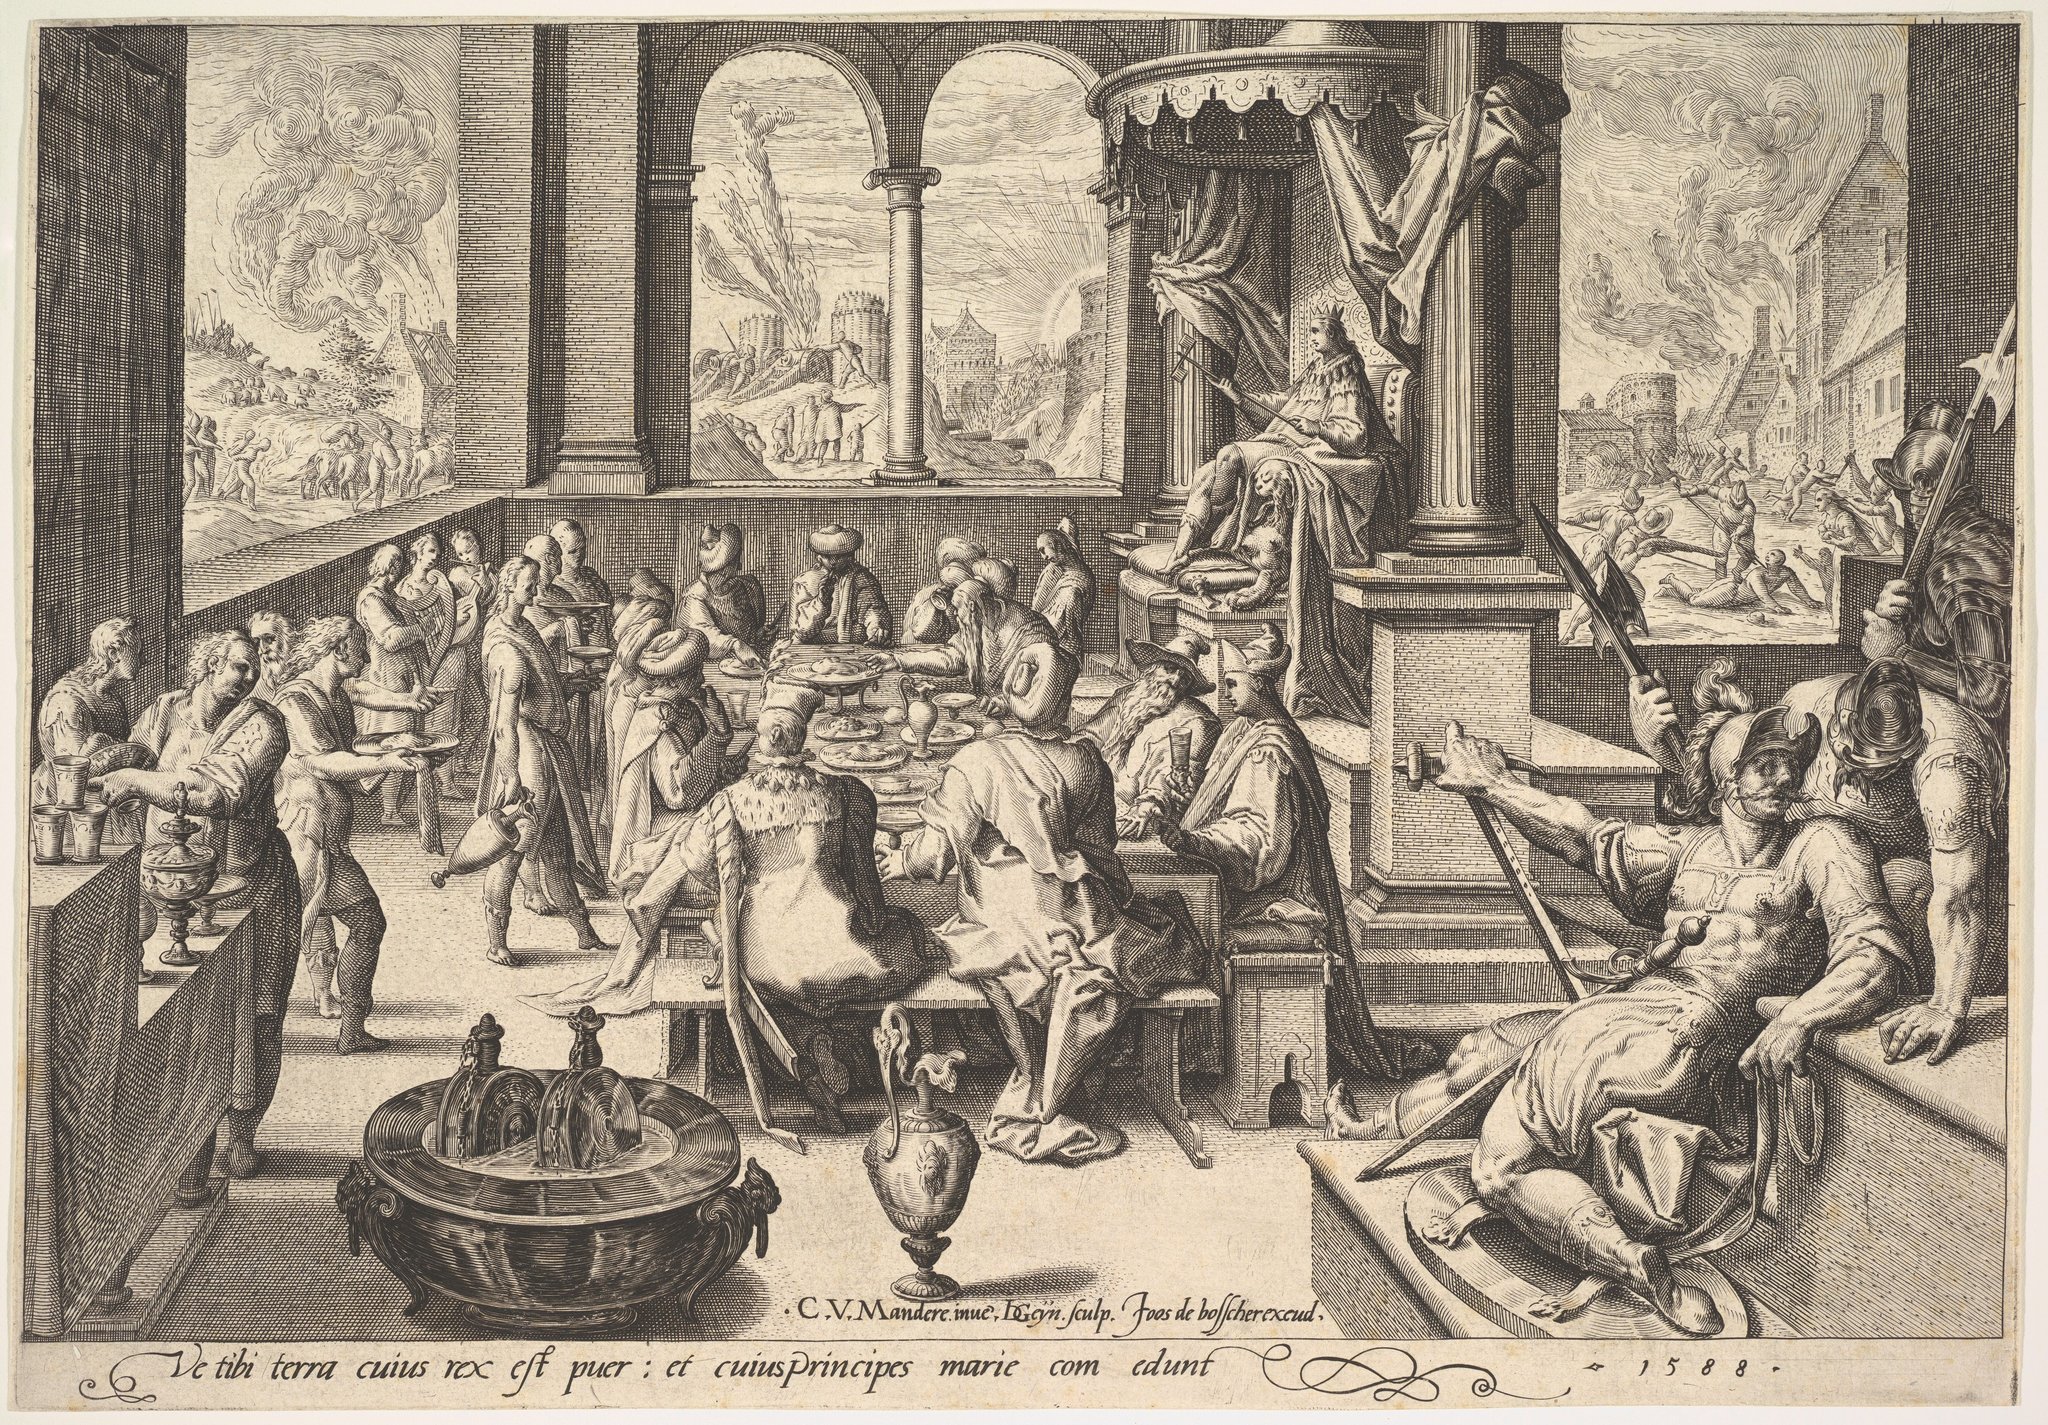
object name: print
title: Allegory of the Government of a Childish King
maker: jacques de gheyn (ii)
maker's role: artist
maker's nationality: netherlandish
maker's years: 1565-1629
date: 1588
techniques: engraving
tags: food,kings,men,dining,allegory